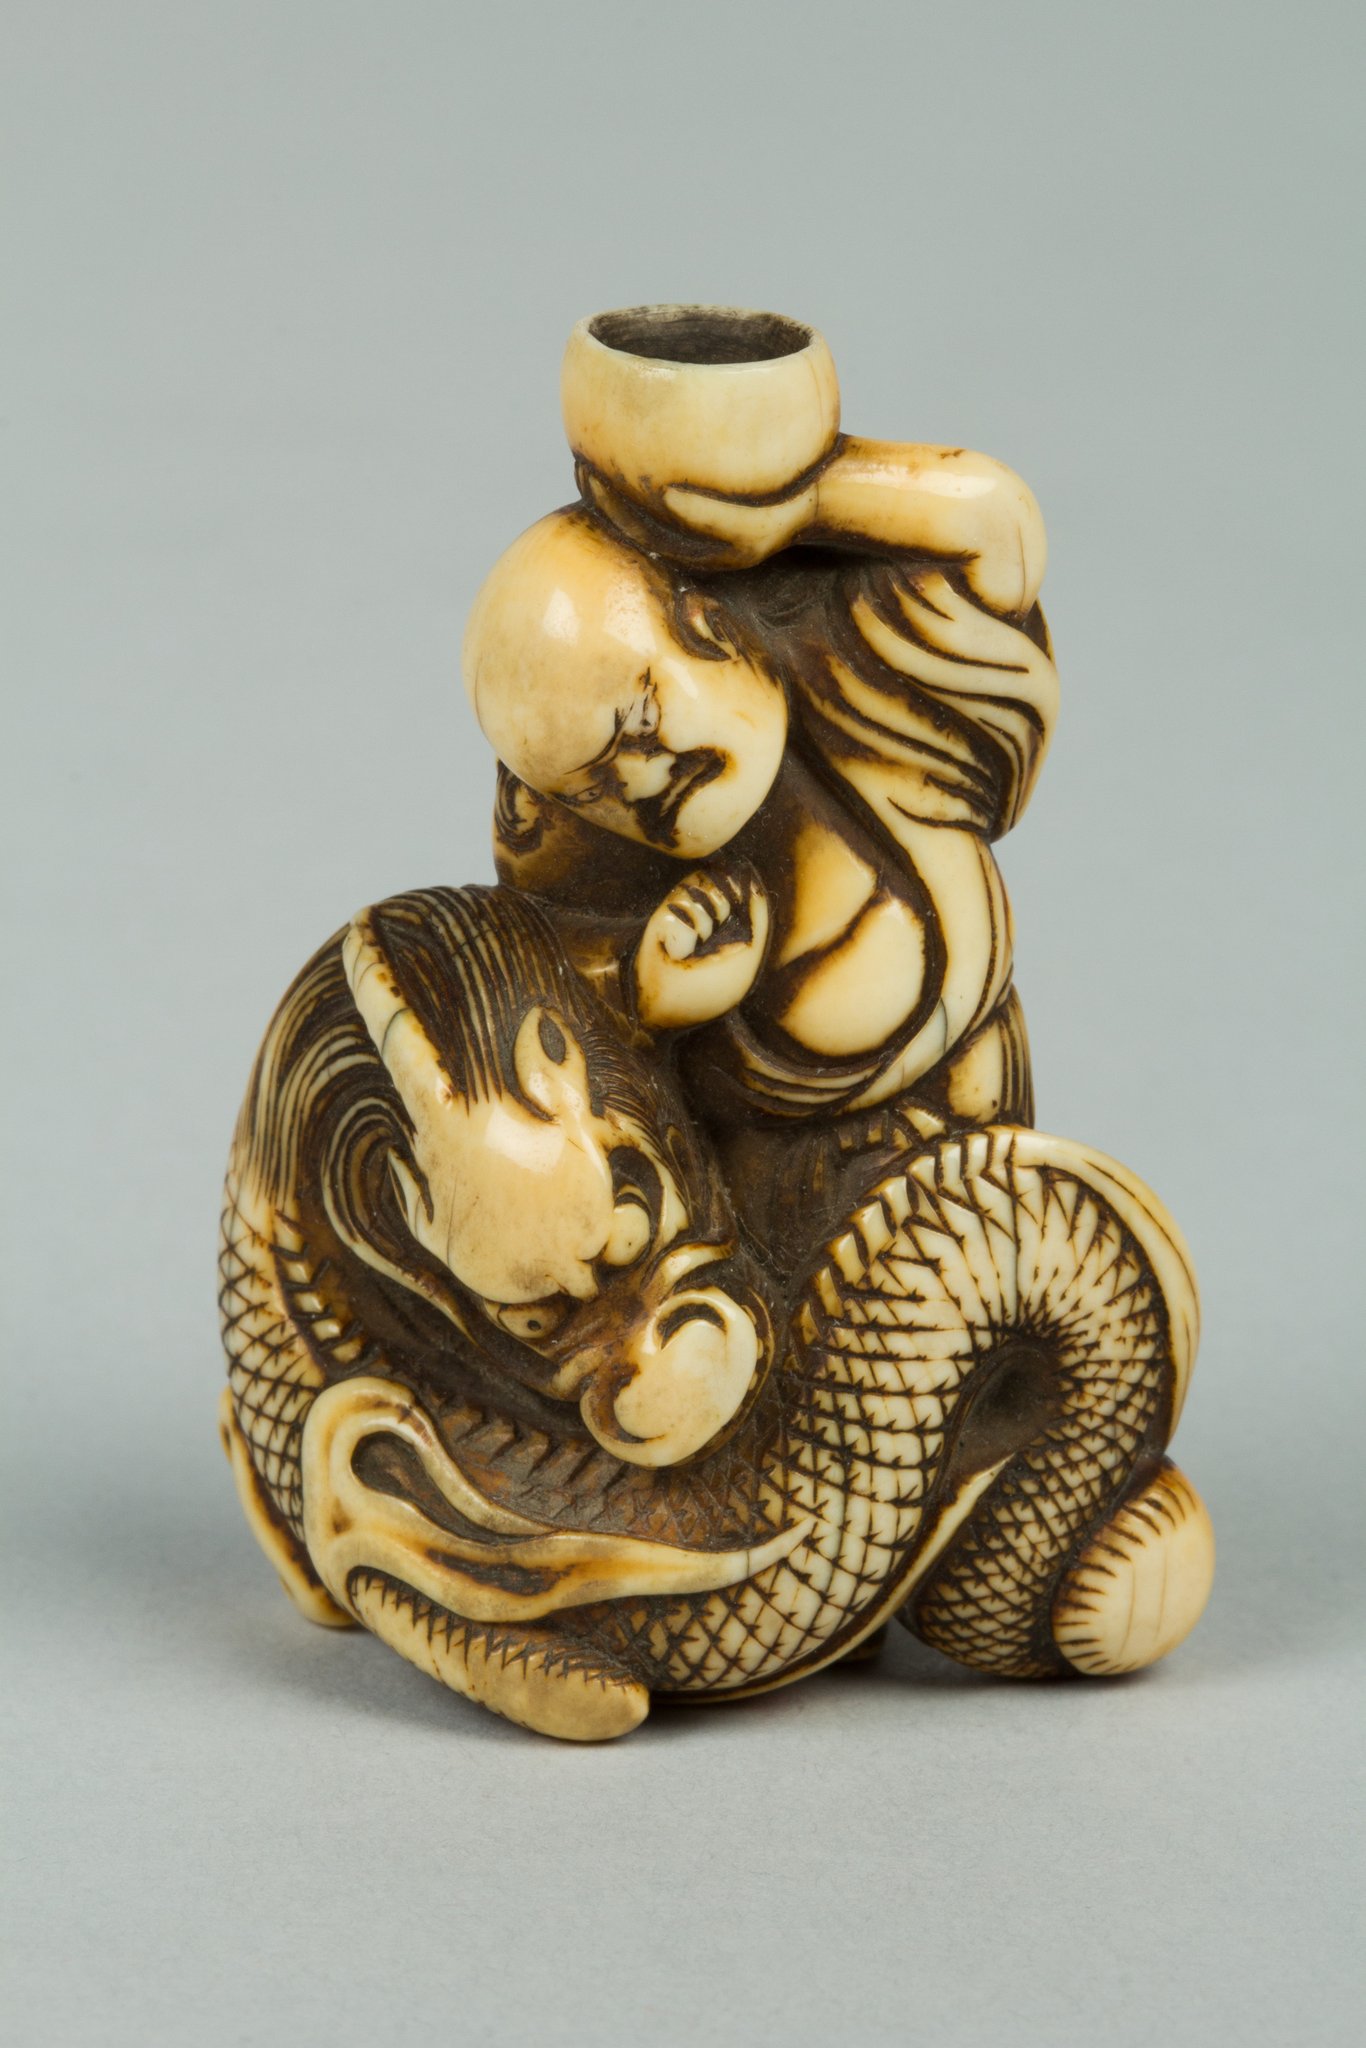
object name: netsuke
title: Netsuke of Man and Dragon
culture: japanese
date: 1801-1900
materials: ivory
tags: dragons